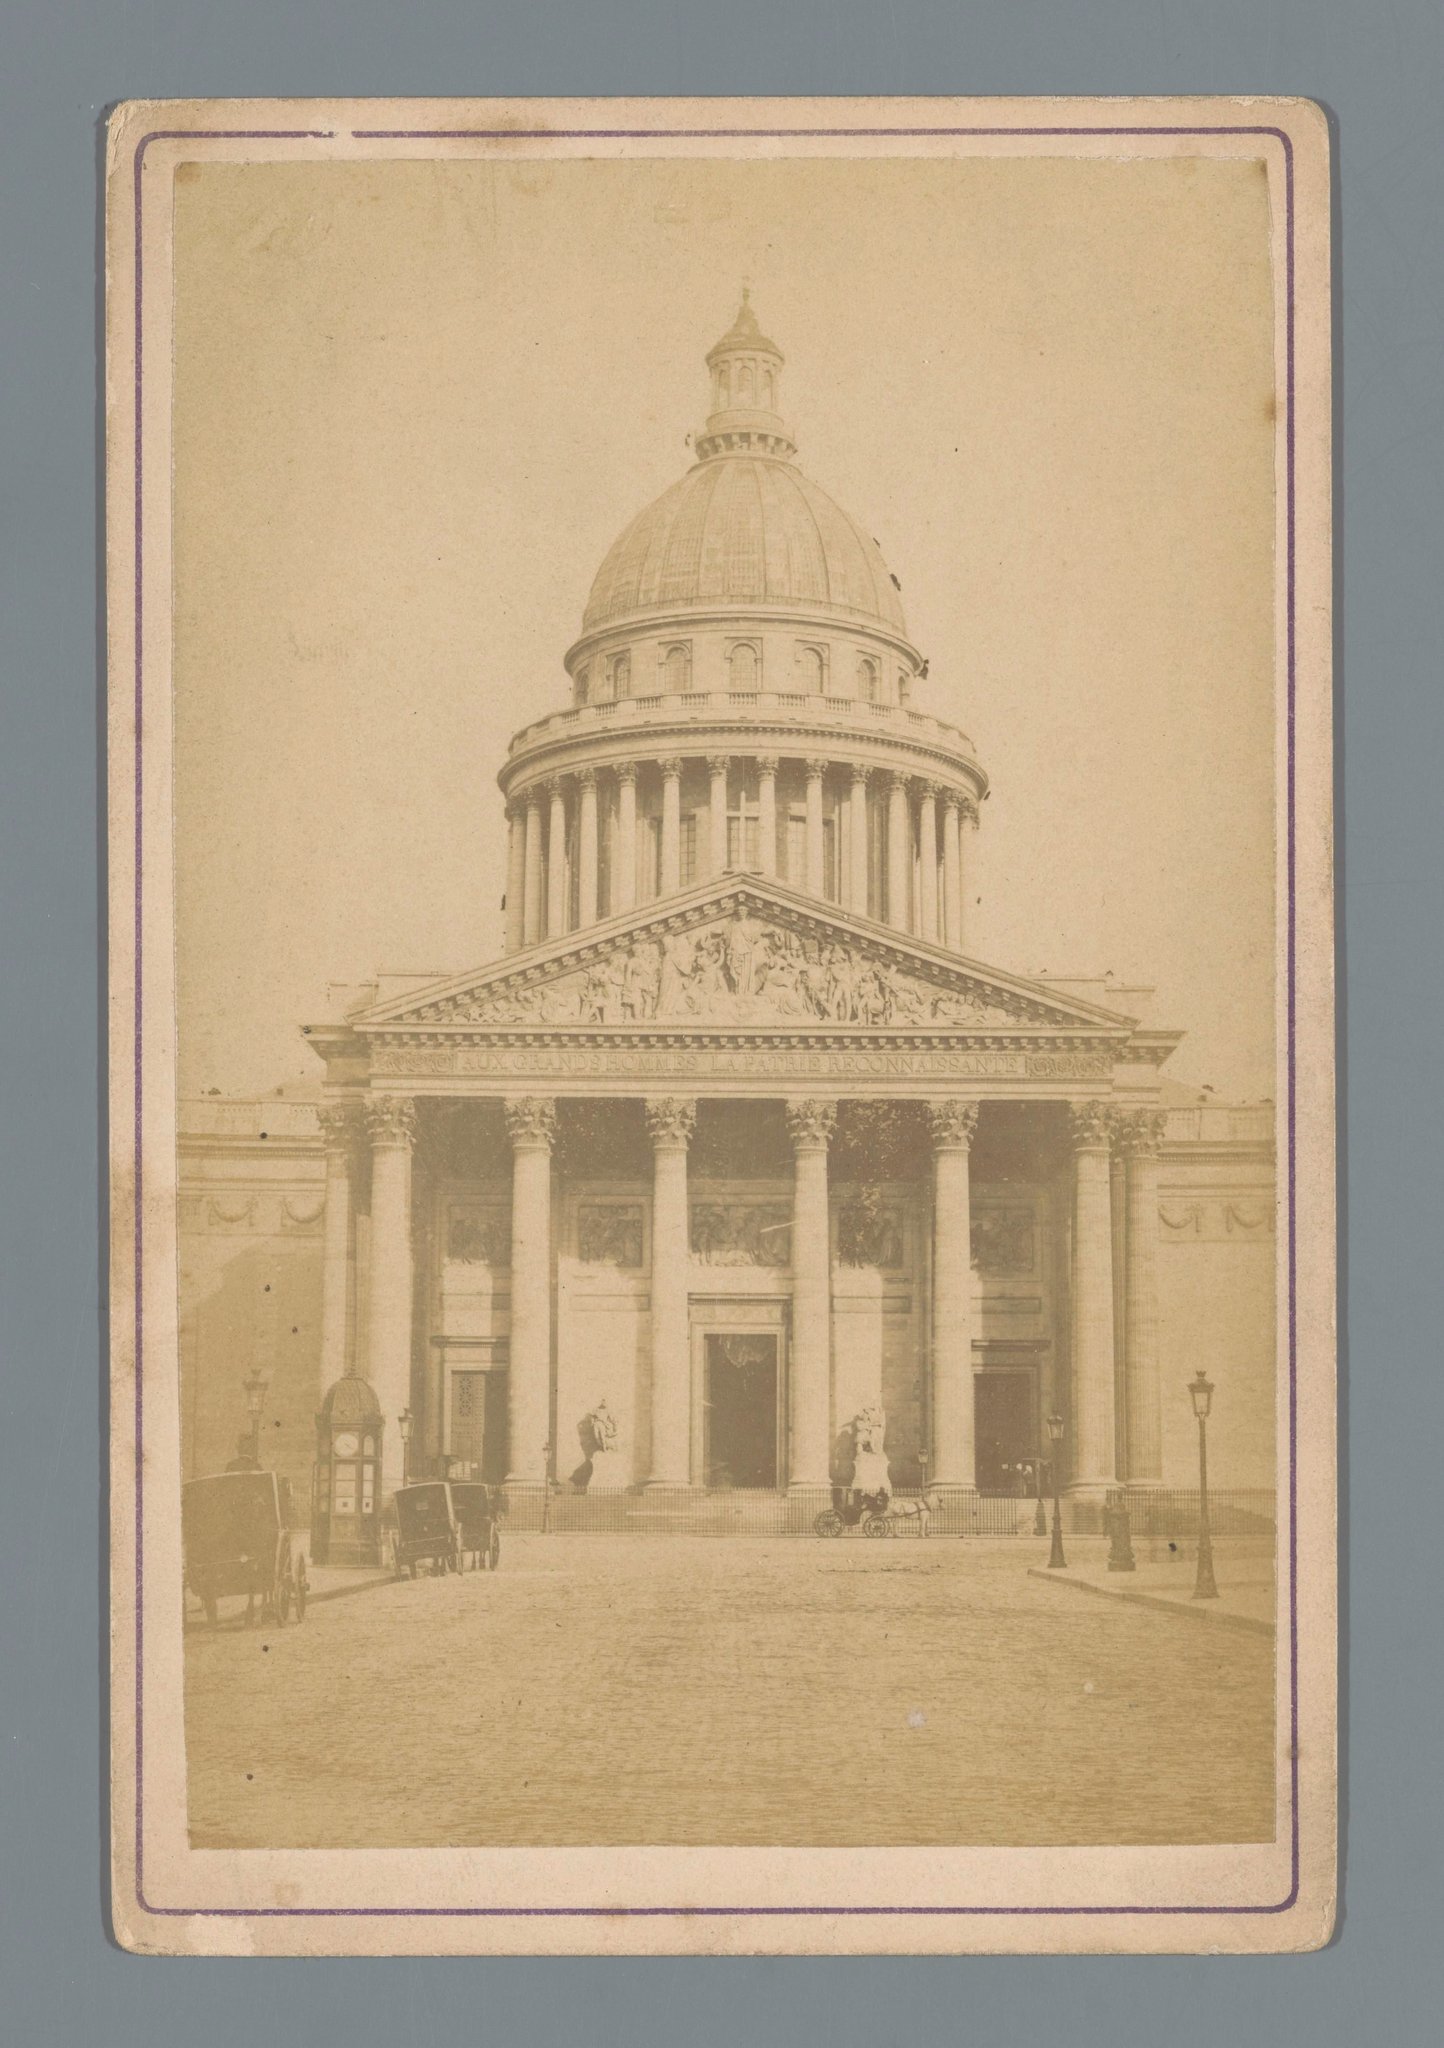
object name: cabinet photograph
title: Gezicht op het Pantheon te Parijs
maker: Anonymous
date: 1860-1890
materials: cardboard, photographic support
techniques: albumen print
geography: paris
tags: church (exterior), façade (of house or building)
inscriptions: annotation: ‘Le Pantheon’